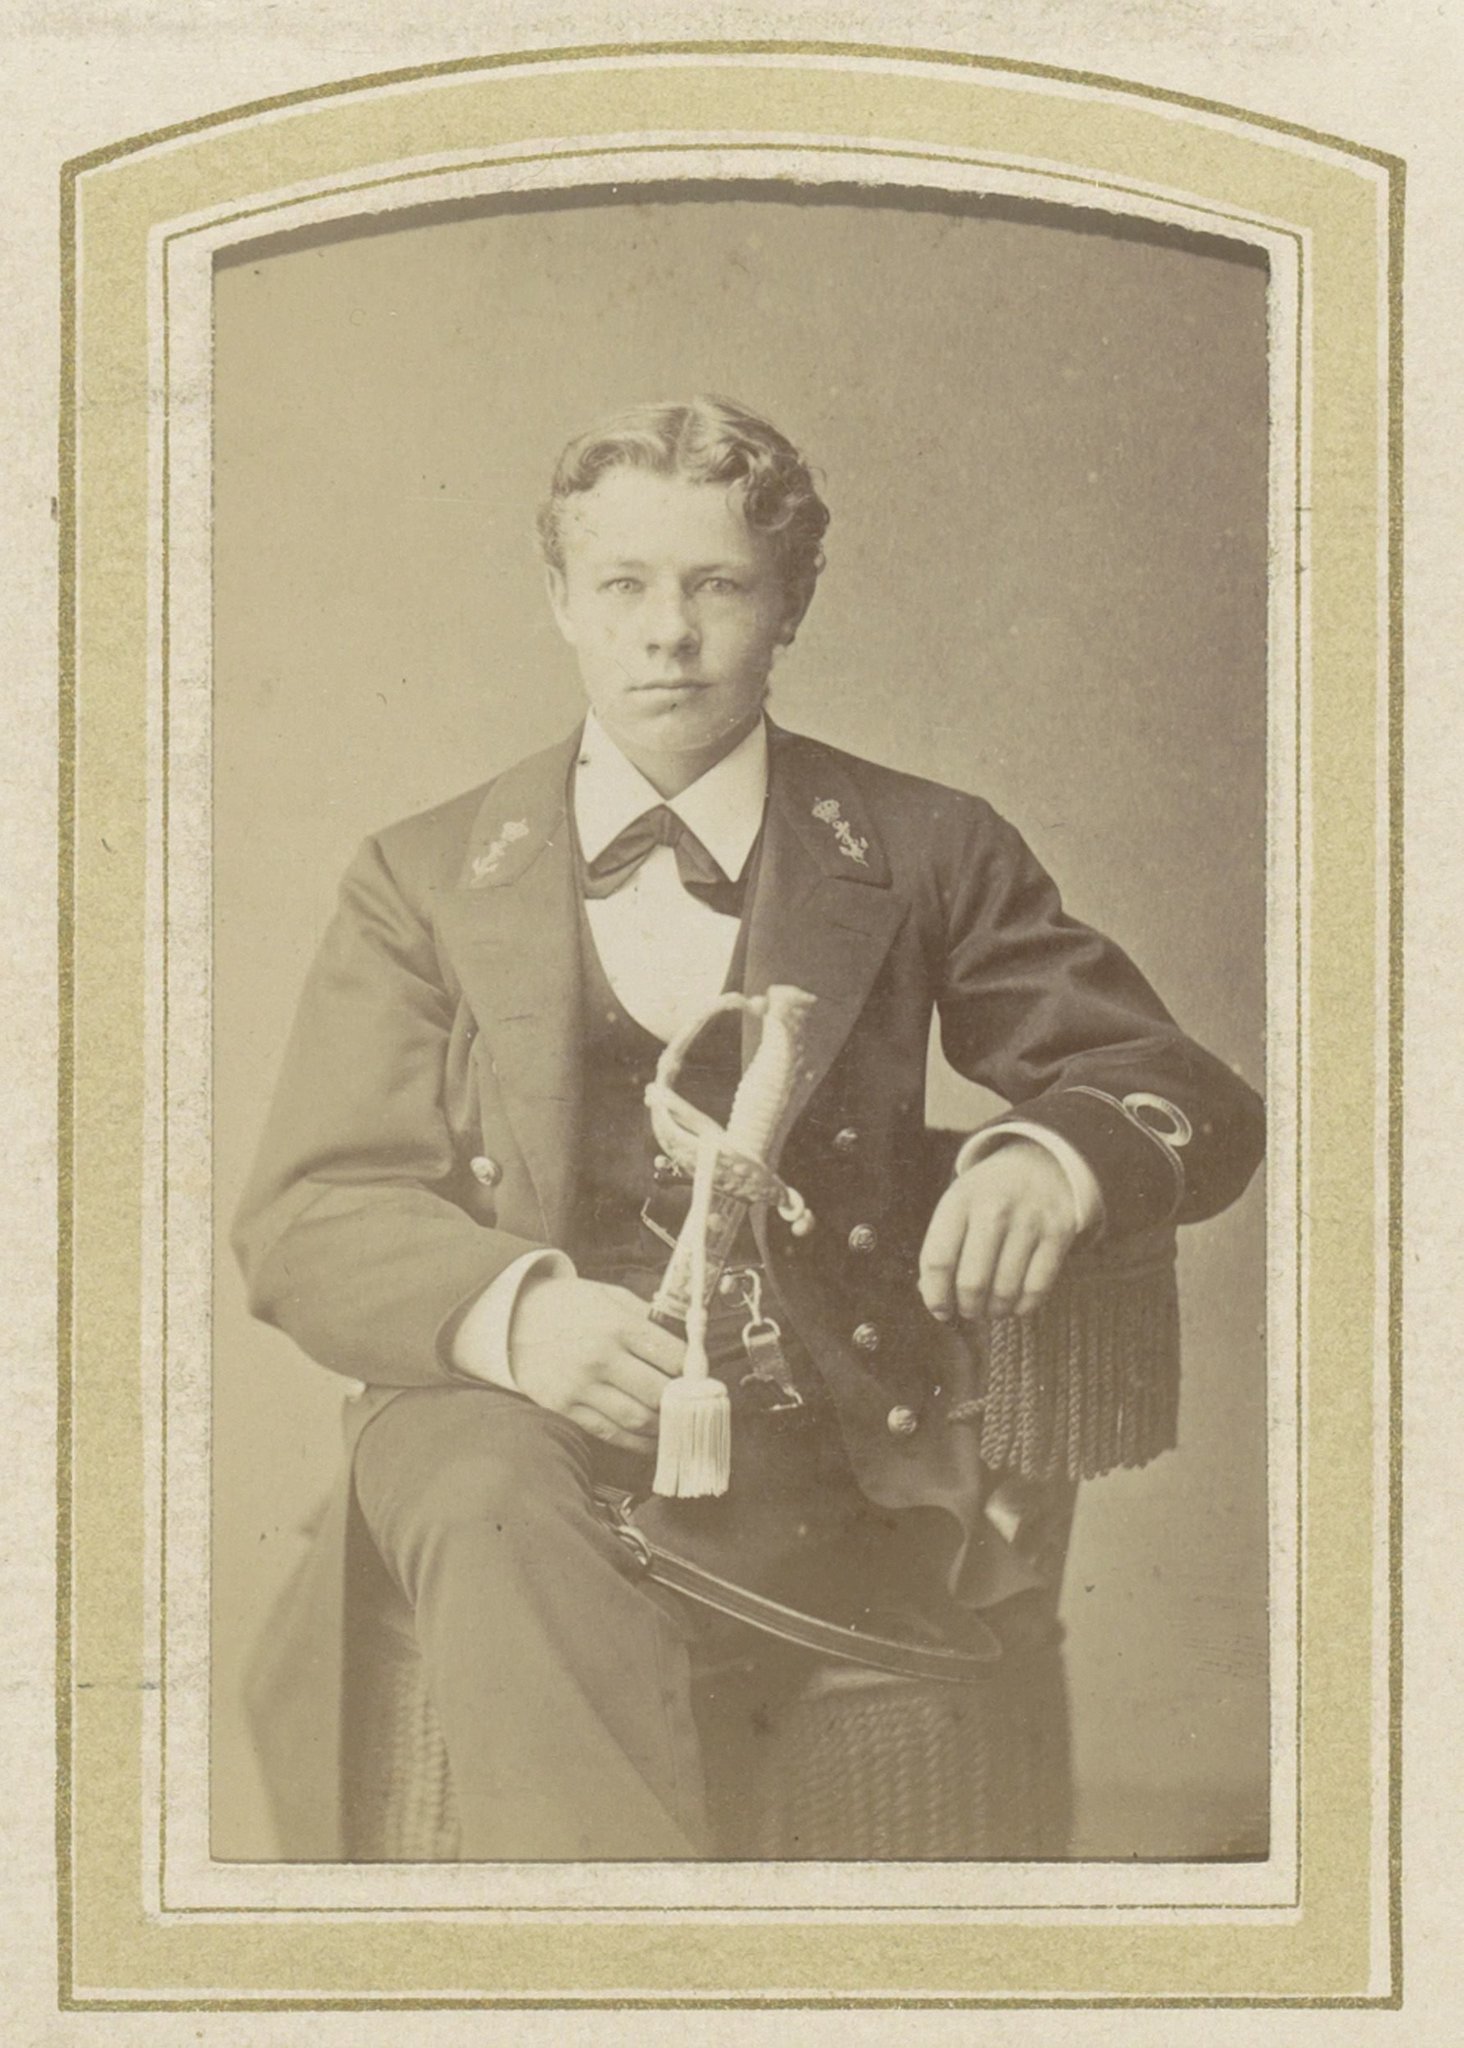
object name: carte de visite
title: Portret van een zittende jongeman met een sabel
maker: abraham koorenhoff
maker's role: fotograaf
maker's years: 1844-1917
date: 1809-1880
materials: cardboard, paper, photographic support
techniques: albumen print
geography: leiden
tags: studio requisites ~ photographer, clothing for the lower part of the body, hacking and thrusting weapons (with name), historical persons, clothing for the upper part of the body, leiden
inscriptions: inscription: ‘september 1880’, address: ‘Leiden’, address: ‘Gerecht No. 5 bij de Pieterskerk’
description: Onderdeel van Fotoalbum van een Nederlandse familie met 168 cartes-de-visite en kabinetfoto's.